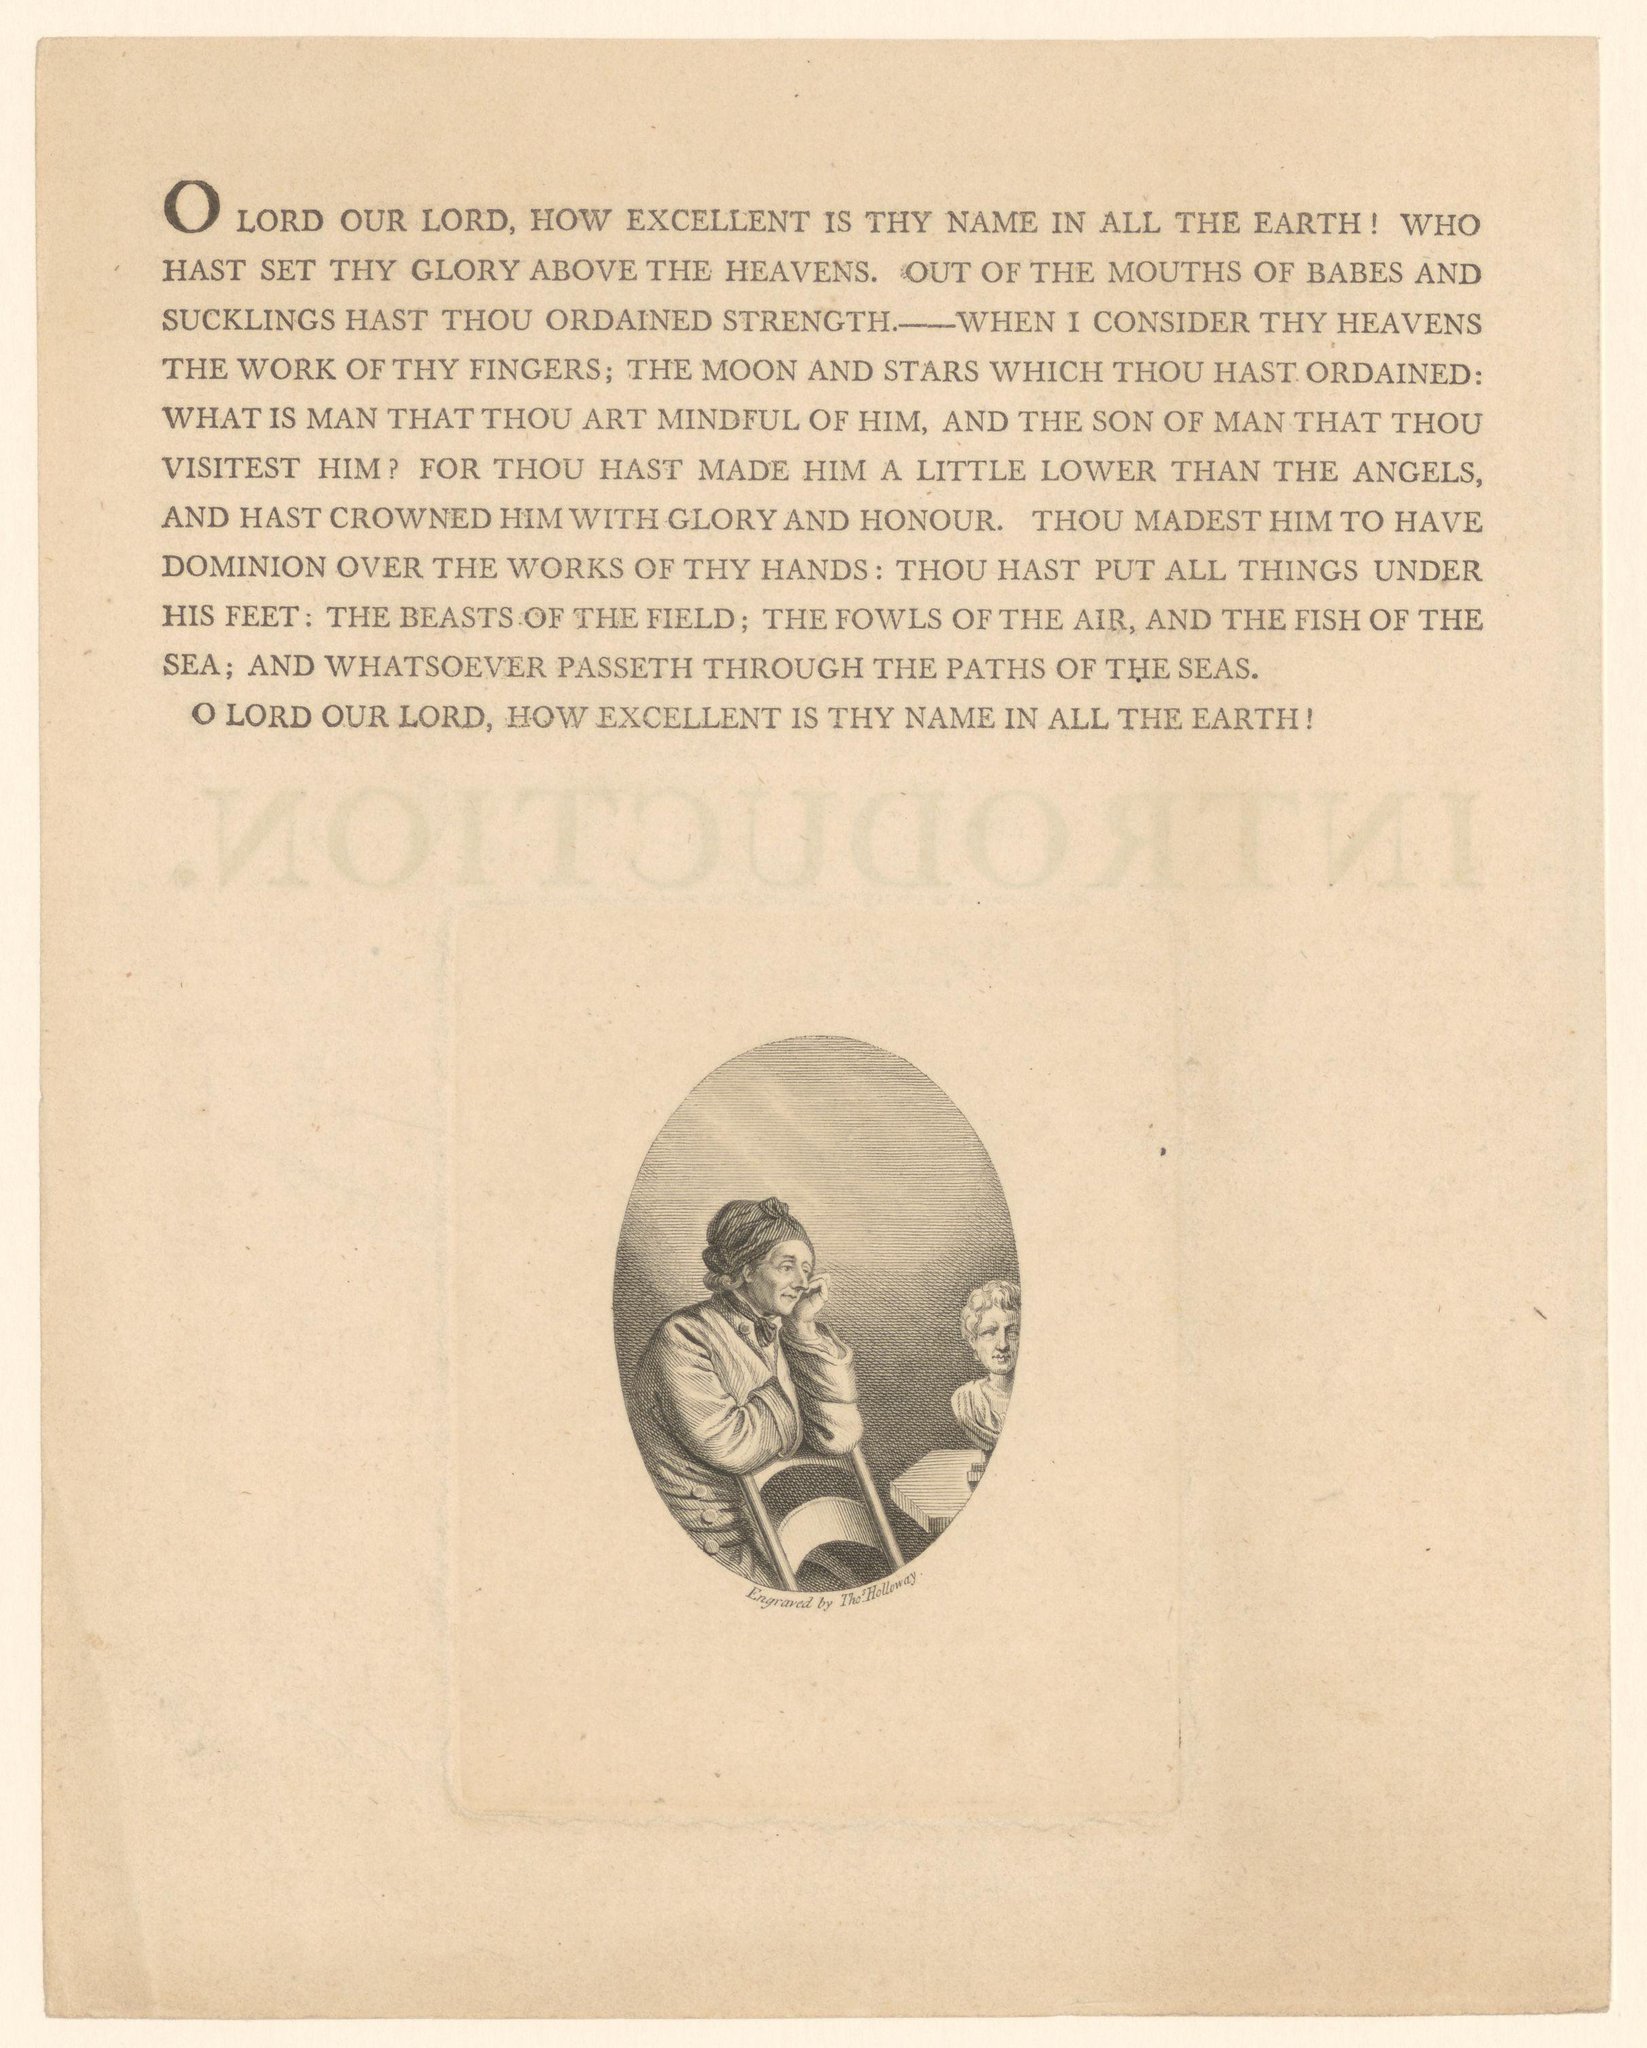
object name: book illustration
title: Man leunt met zijn elleboog op de rand van een stoel, mogelijk portret van Johann Caspar Lavater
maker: thomas holloway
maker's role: print maker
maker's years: 1748-1827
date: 1789-1798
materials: paper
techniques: engraving, etching, letterpress printing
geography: london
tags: johann caspar lavater, historical persons, sculpture, head held in the hand(s), with elbows leaning on an elevation or on the knees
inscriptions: collector's mark: Lugt 2228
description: Prent uit een niet geïdentificeerde publicatie, mogelijk: Lavater, Johann Kaspar. Essays on Physiognomy (...). [Vertaald uit het Frans door] Henry Hunter. Londen: John Murray, 1789-1798.